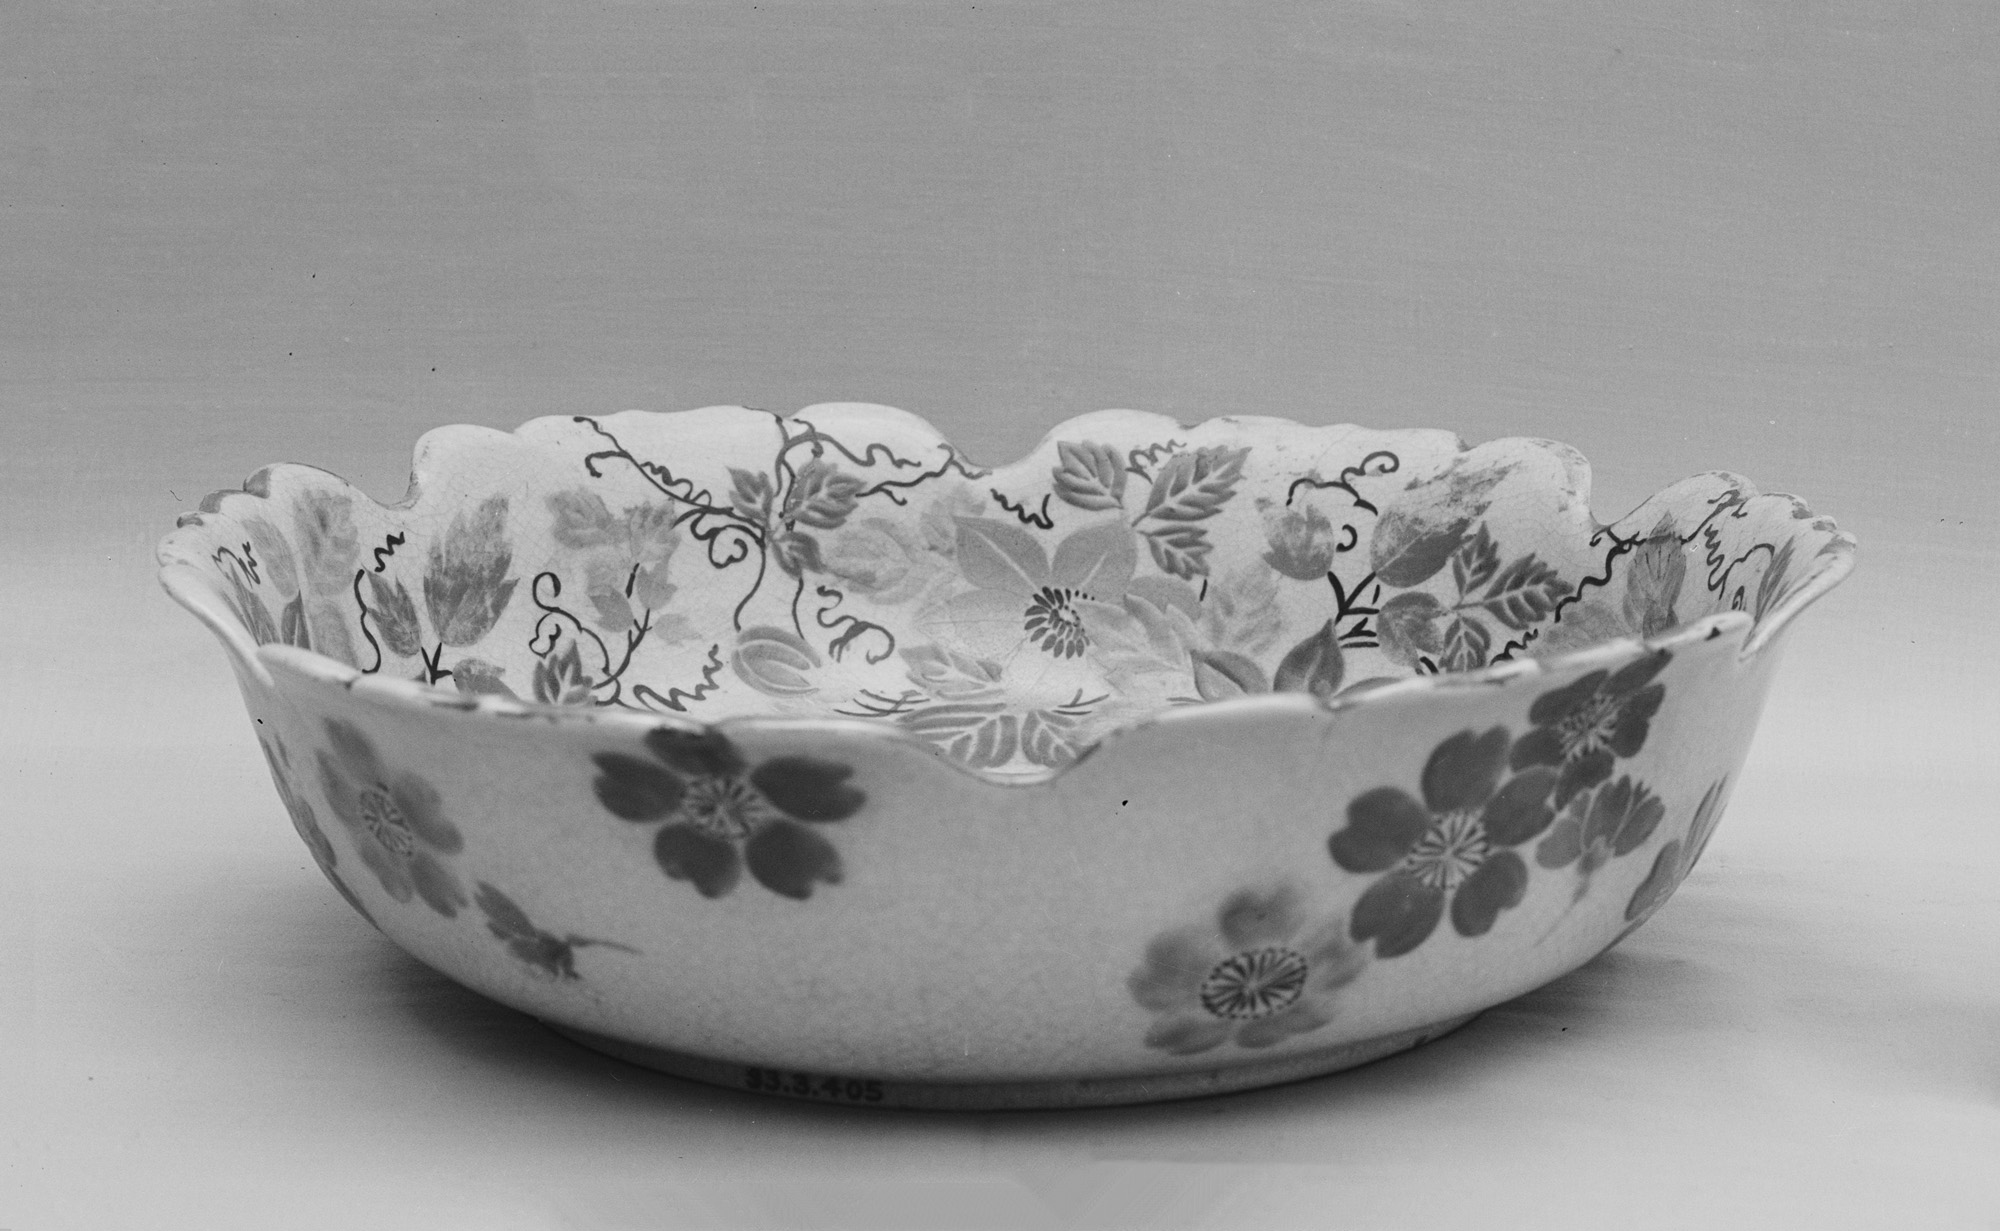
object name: bowl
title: Large Bowl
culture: japanese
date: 1800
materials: clay, enamel, glaze, gold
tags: flowers